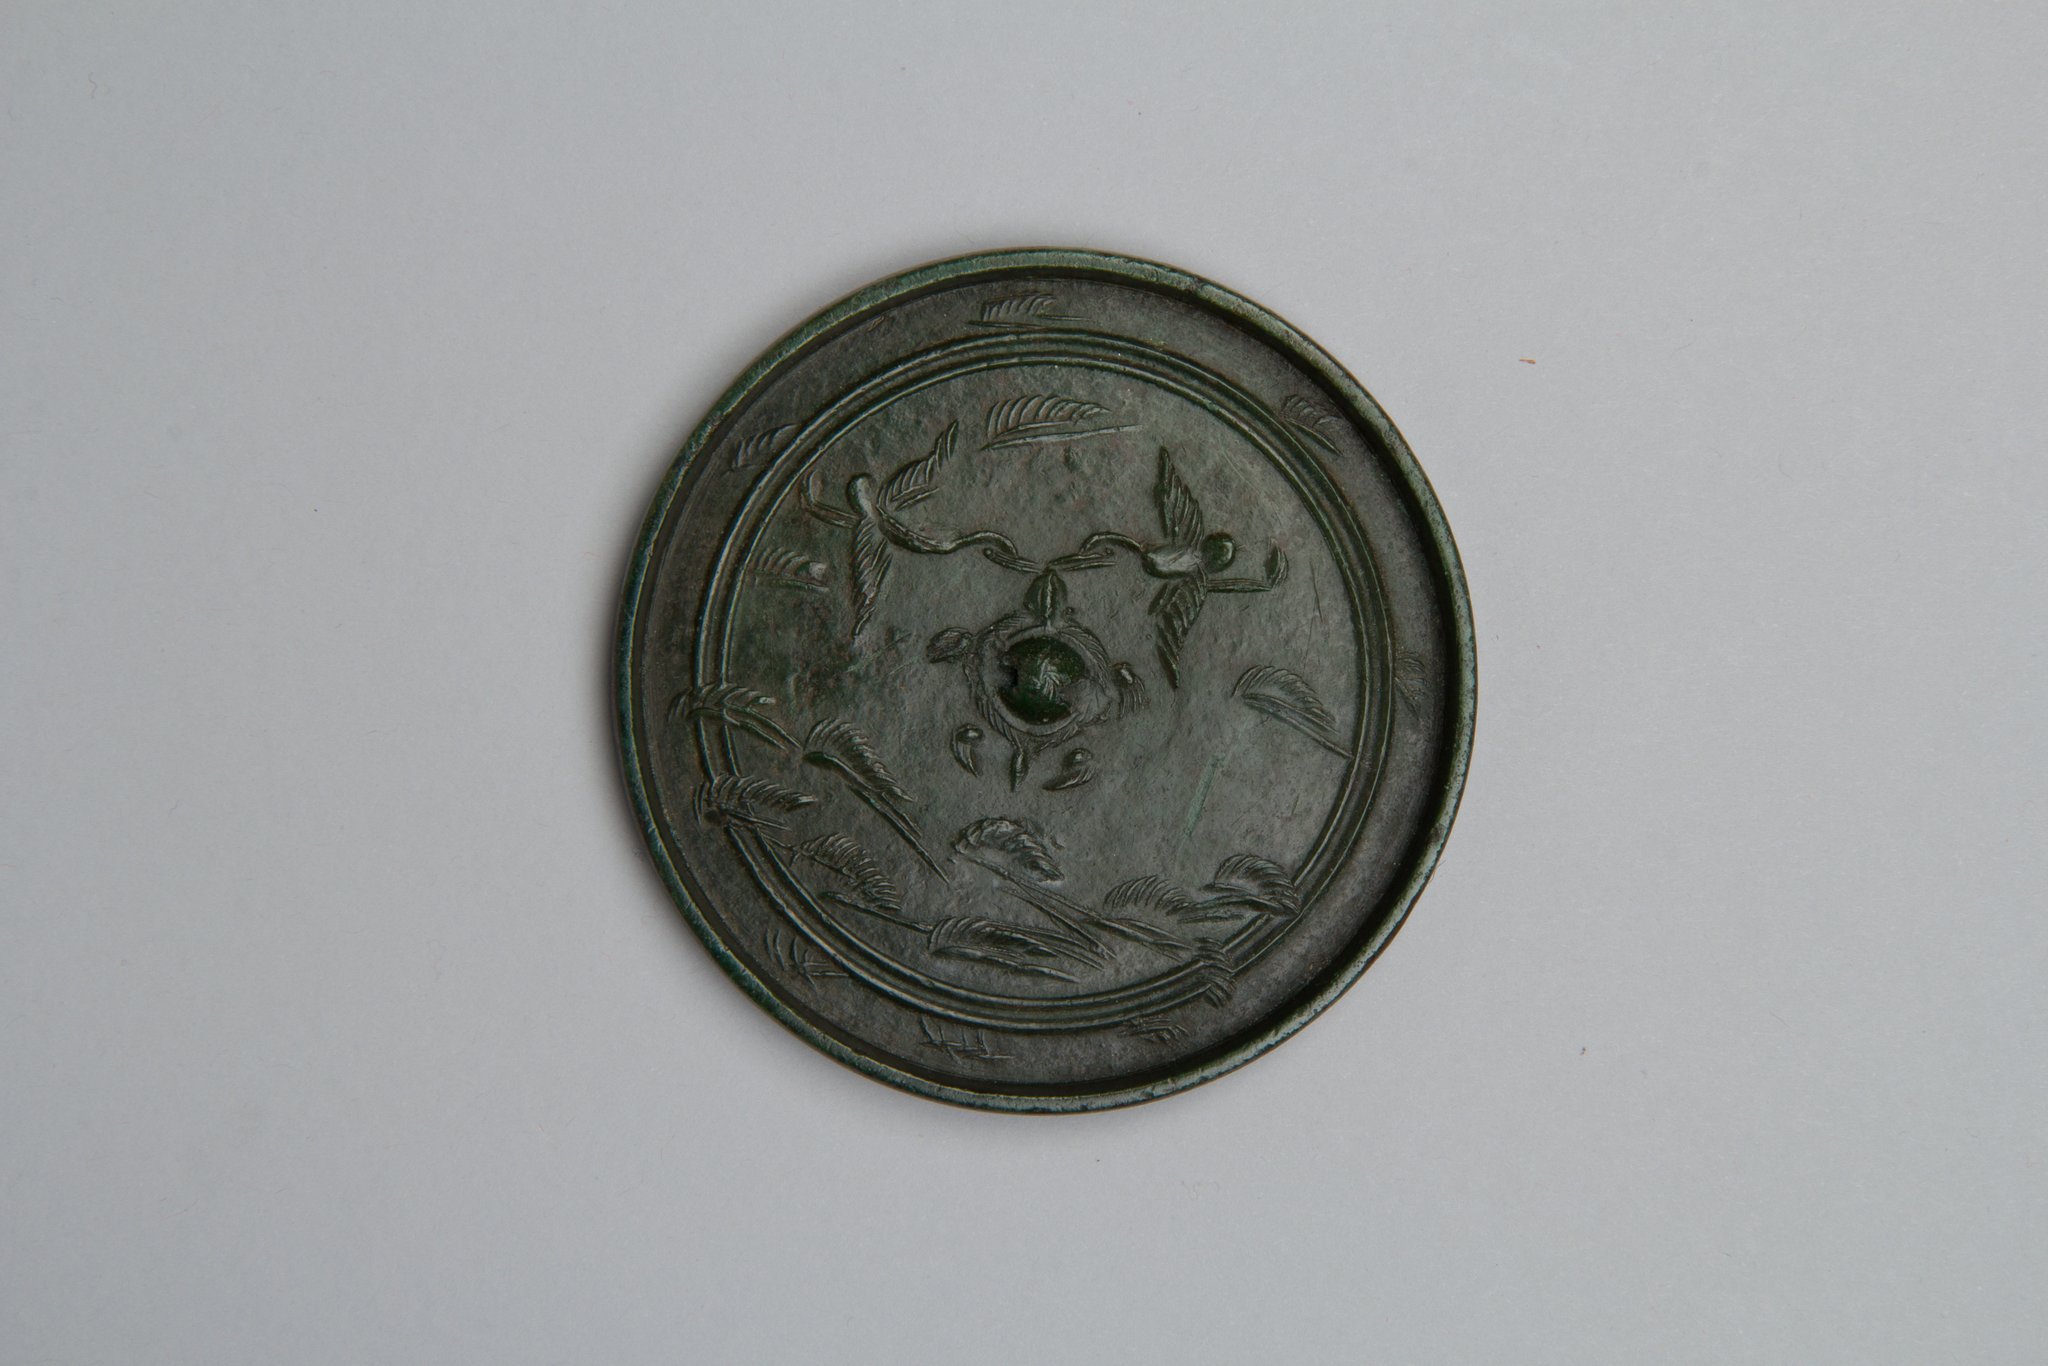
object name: mirror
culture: japanese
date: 1336-1392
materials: bronze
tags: birds